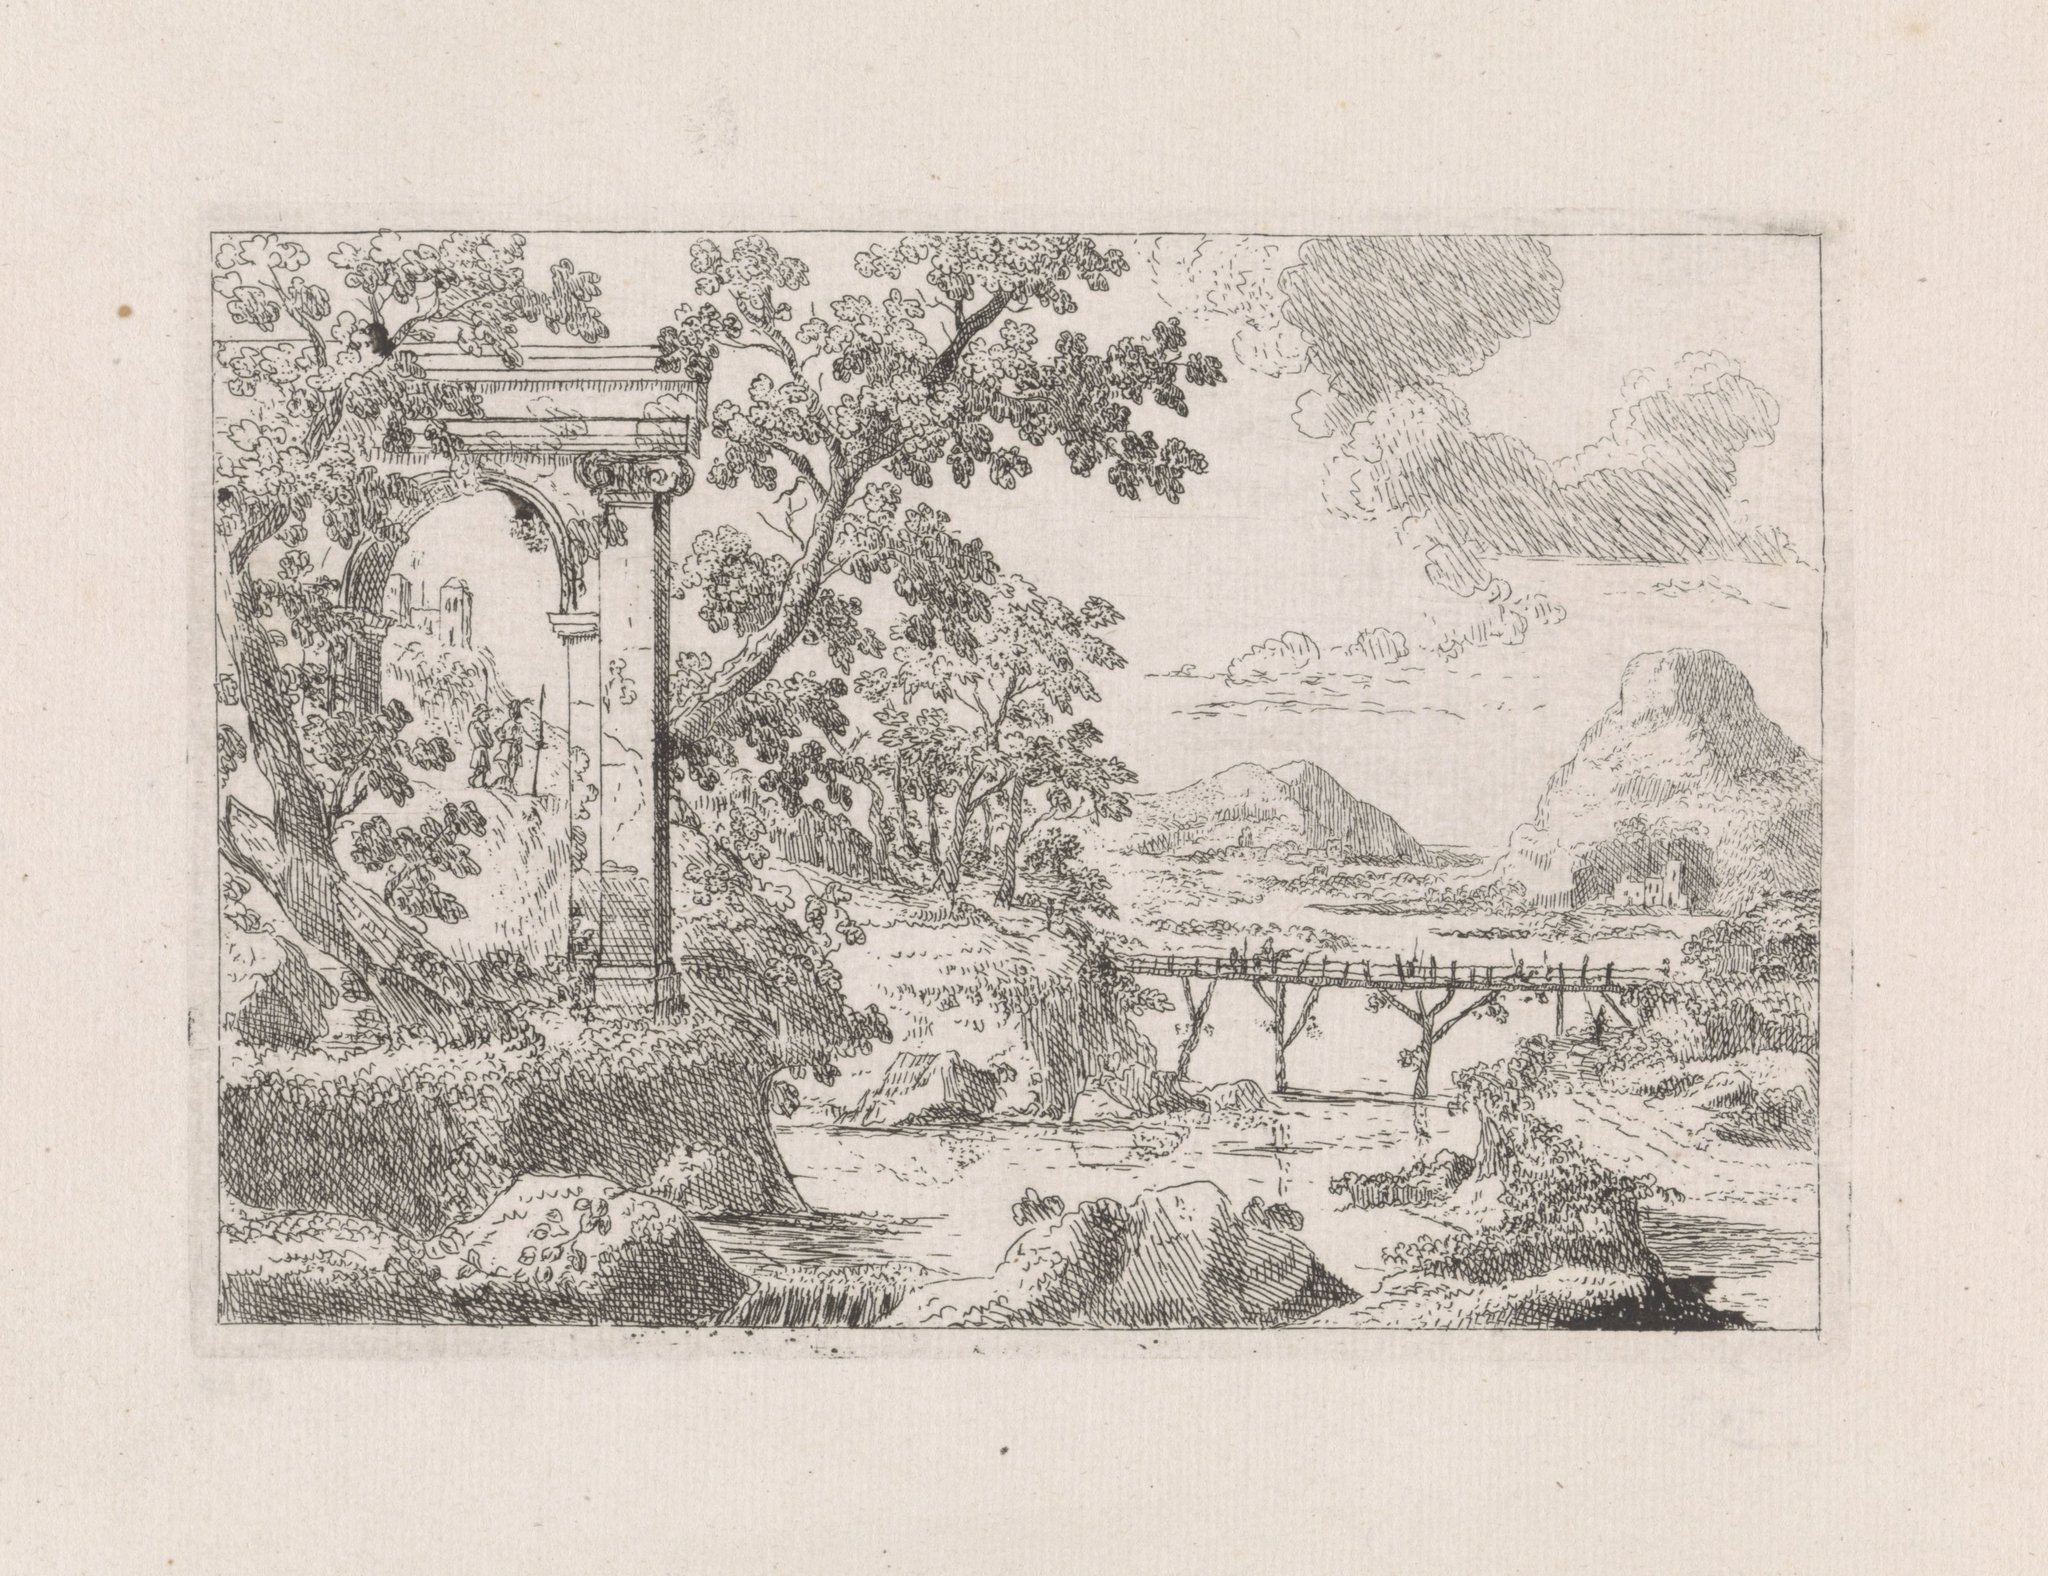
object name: print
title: Rivierlandschap met houten brug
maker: pieter langendijk (i)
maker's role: print maker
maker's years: 1683-1756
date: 1693-1756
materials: paper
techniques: etching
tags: landscape with ruins - ii - ideal landscapes (+ variant), bridge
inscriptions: collector's mark: Lugt 240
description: Rivierlandschap met in de verte een lange houten brug waar figuren overheen lopen. Links staat op de oever een restant van een antiek bouwwerk.